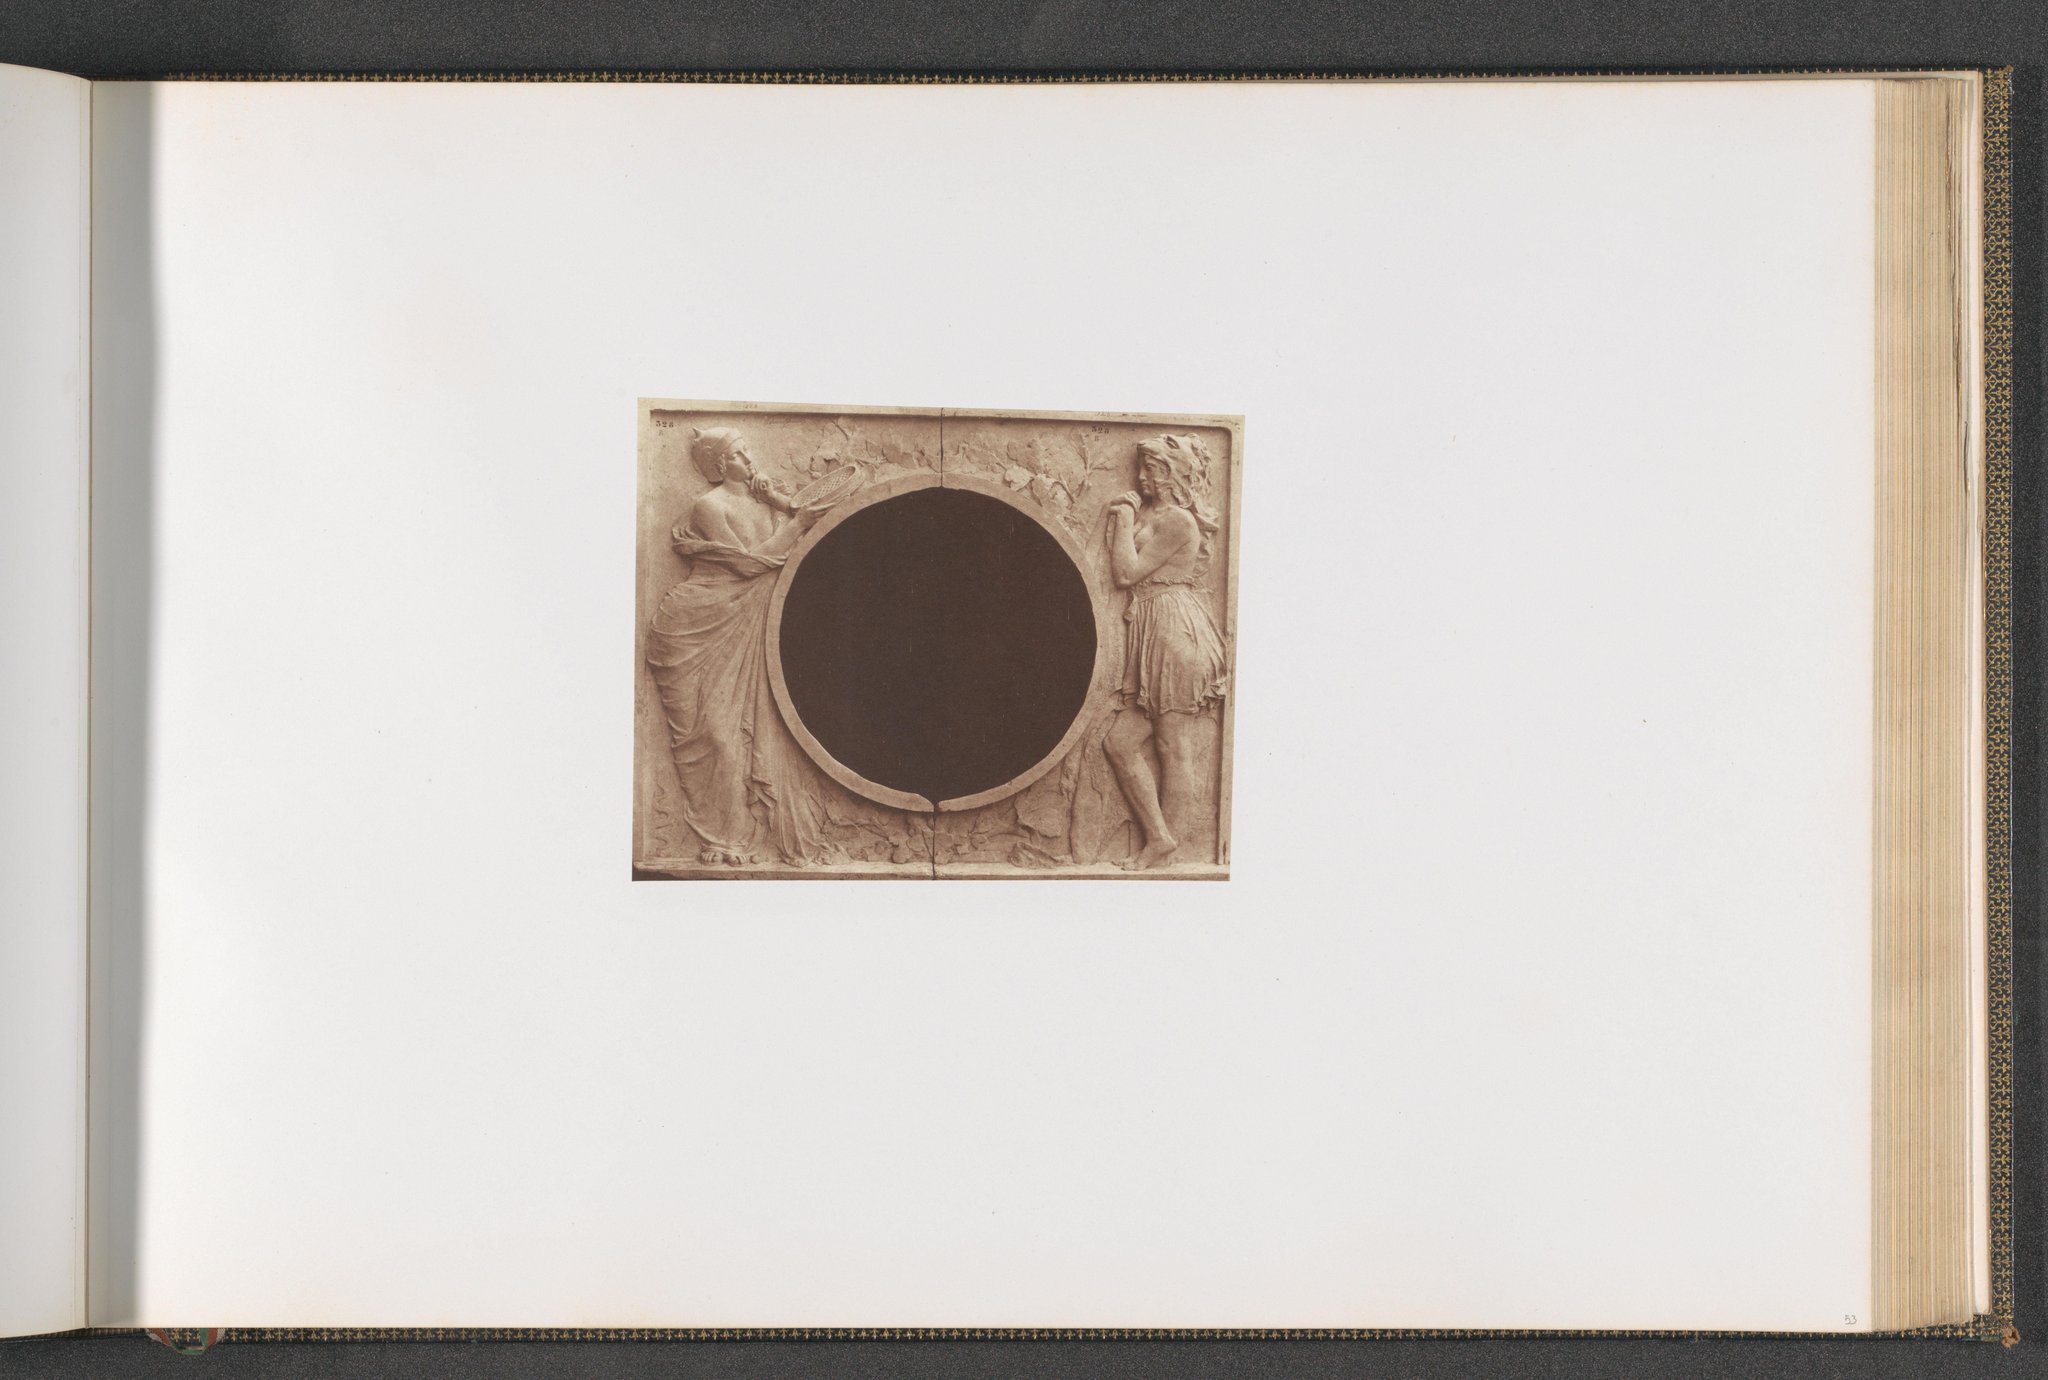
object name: album leaf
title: Gipsmodellen voor beeldhouwwerken op het Palais du Louvre: "La Justice et la Fraternité door Victor Edmond Leharivel-Durocher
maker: édouard denis baldus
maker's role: fotograaf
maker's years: 1813-1889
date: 1855-1857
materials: paper, photographic support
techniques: salted paper print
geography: paris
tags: piece of sculpture, reproduction of a piece of sculpture, permanent exhibition, museum, paris, tuileries palace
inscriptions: number: ‘328B’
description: Onderdeel van Réunion des Tuileries au Louvre 1852-1857, album 2.